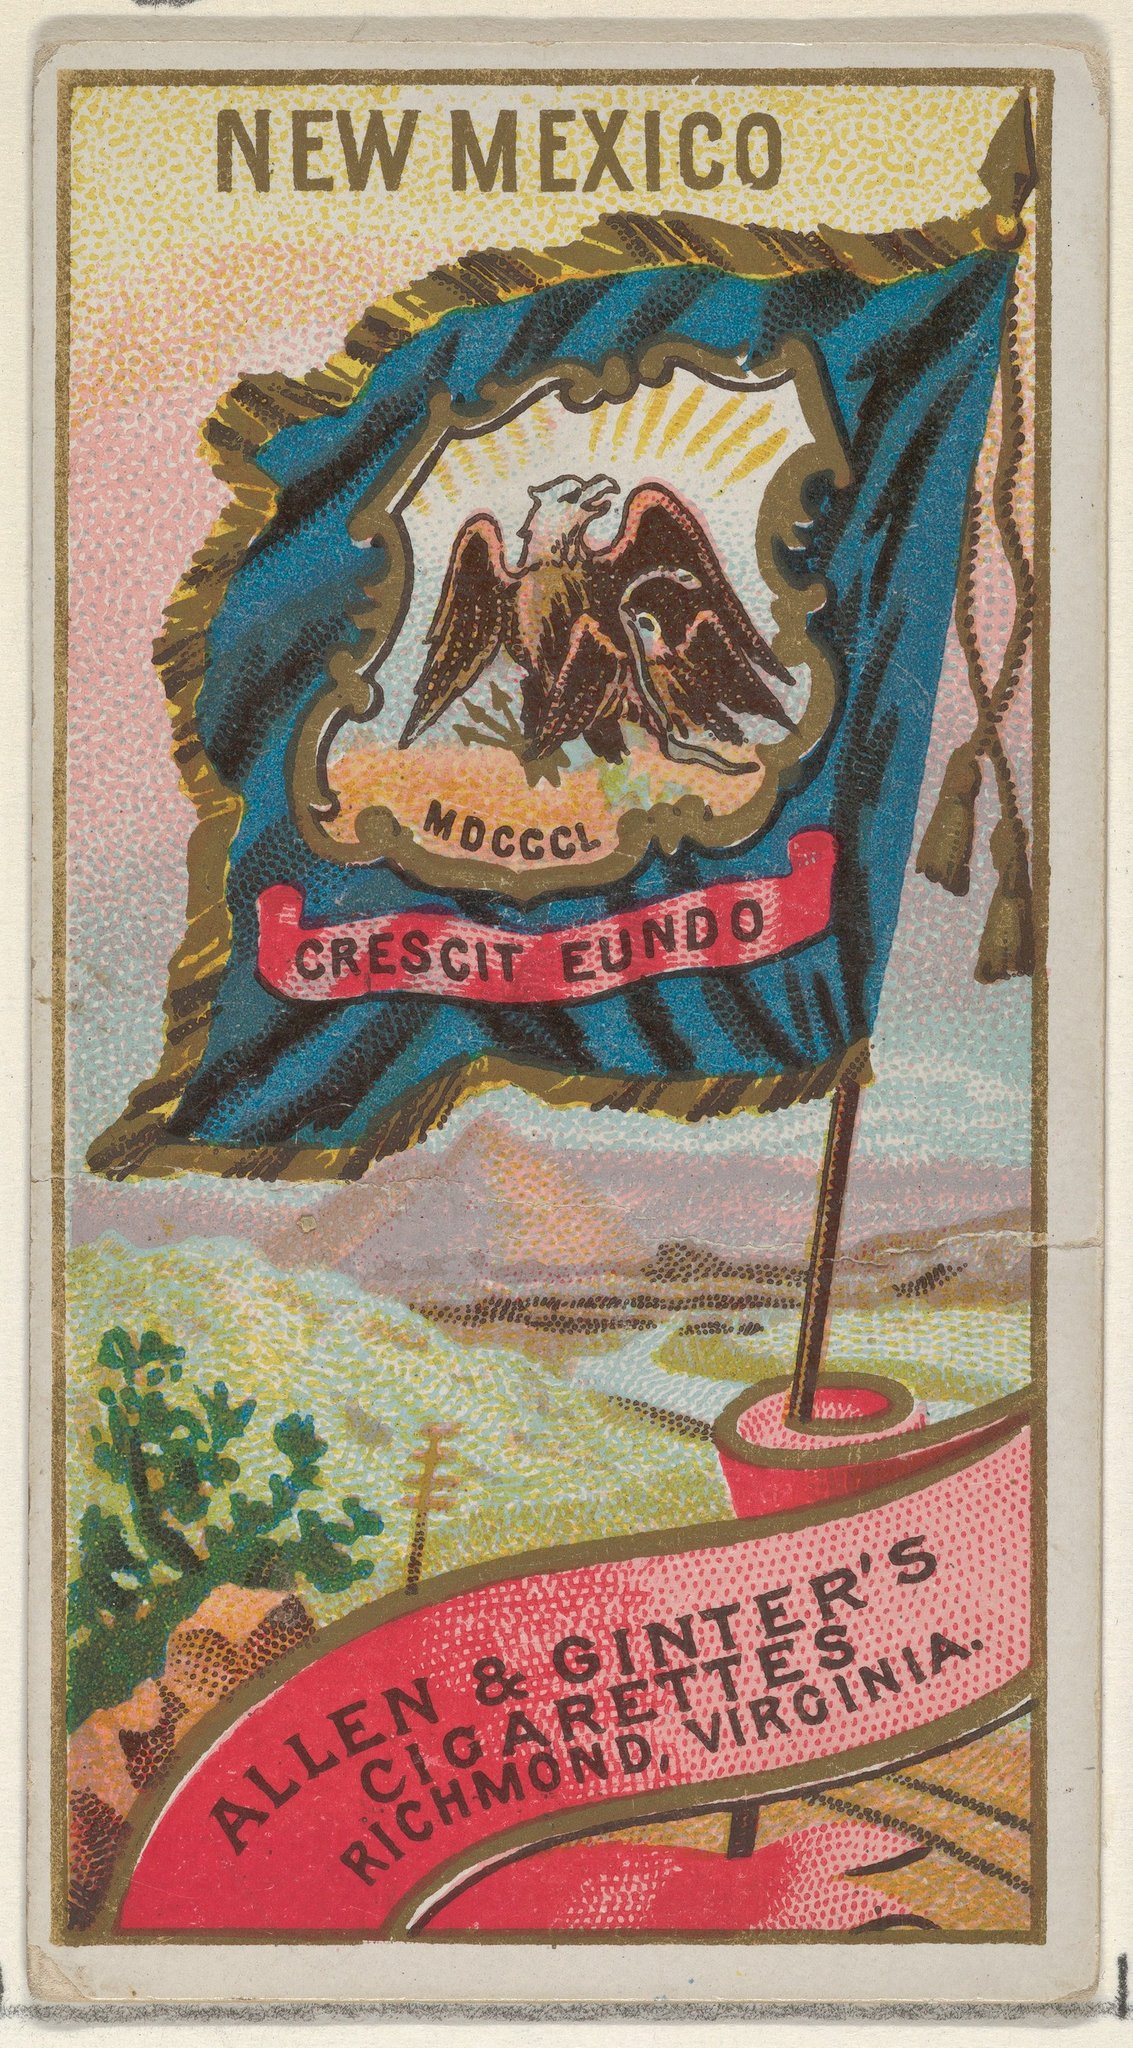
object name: print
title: New Mexico, from Flags of the States and Territories (N11) for Allen & Ginter Cigarettes Brands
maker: allen & ginter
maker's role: publisher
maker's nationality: american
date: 1888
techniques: color lithograph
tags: flags